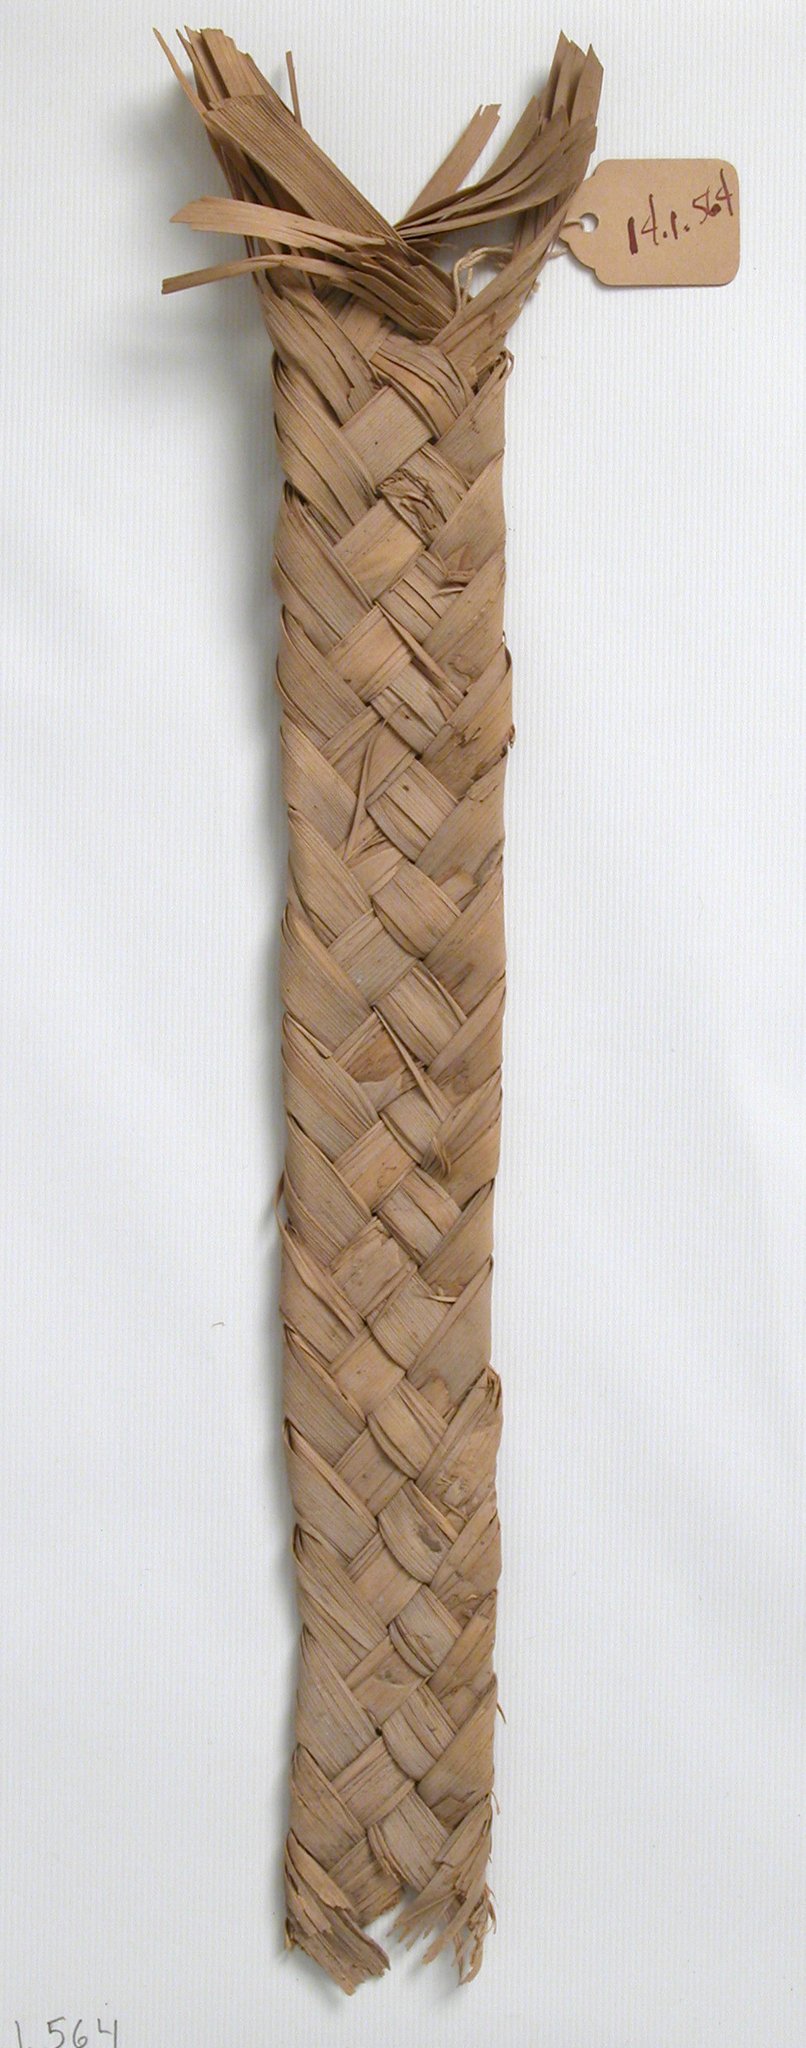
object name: braid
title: Palm Leaf Braid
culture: coptic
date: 580-640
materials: fiber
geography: egypt